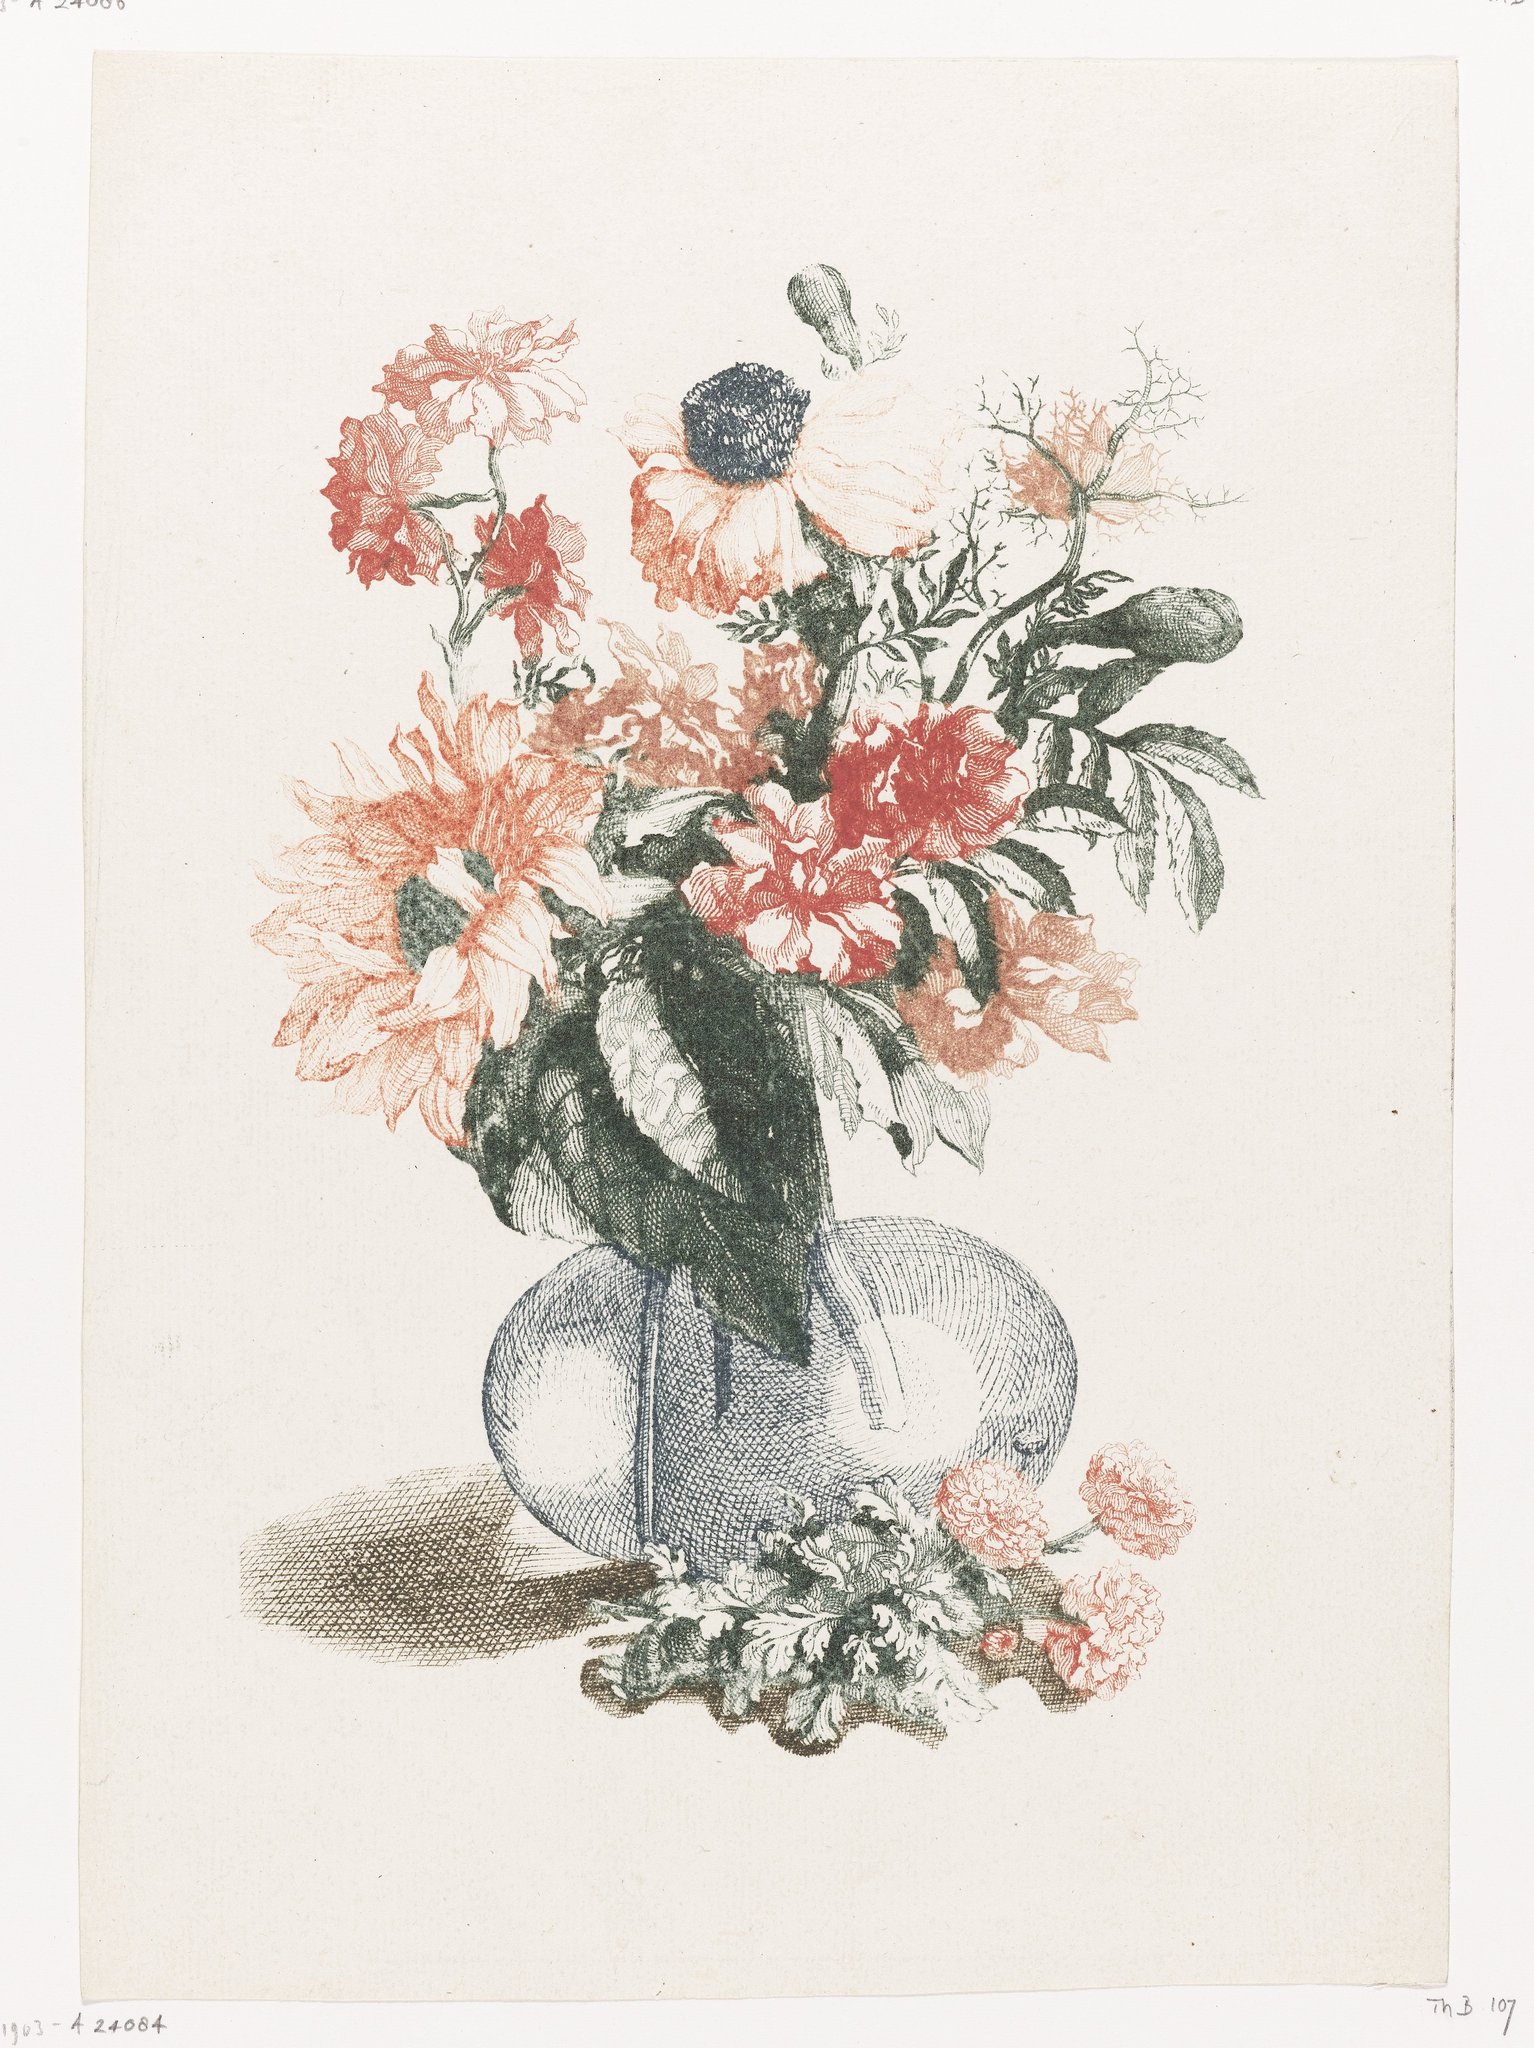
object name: print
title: Glazen vaas met verschillende bloemen en een zonnebloem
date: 1688-1698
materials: paper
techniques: engraving, etching, lithography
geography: netherlands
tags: flowers in a vase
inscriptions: collector's mark: Lugt 2228